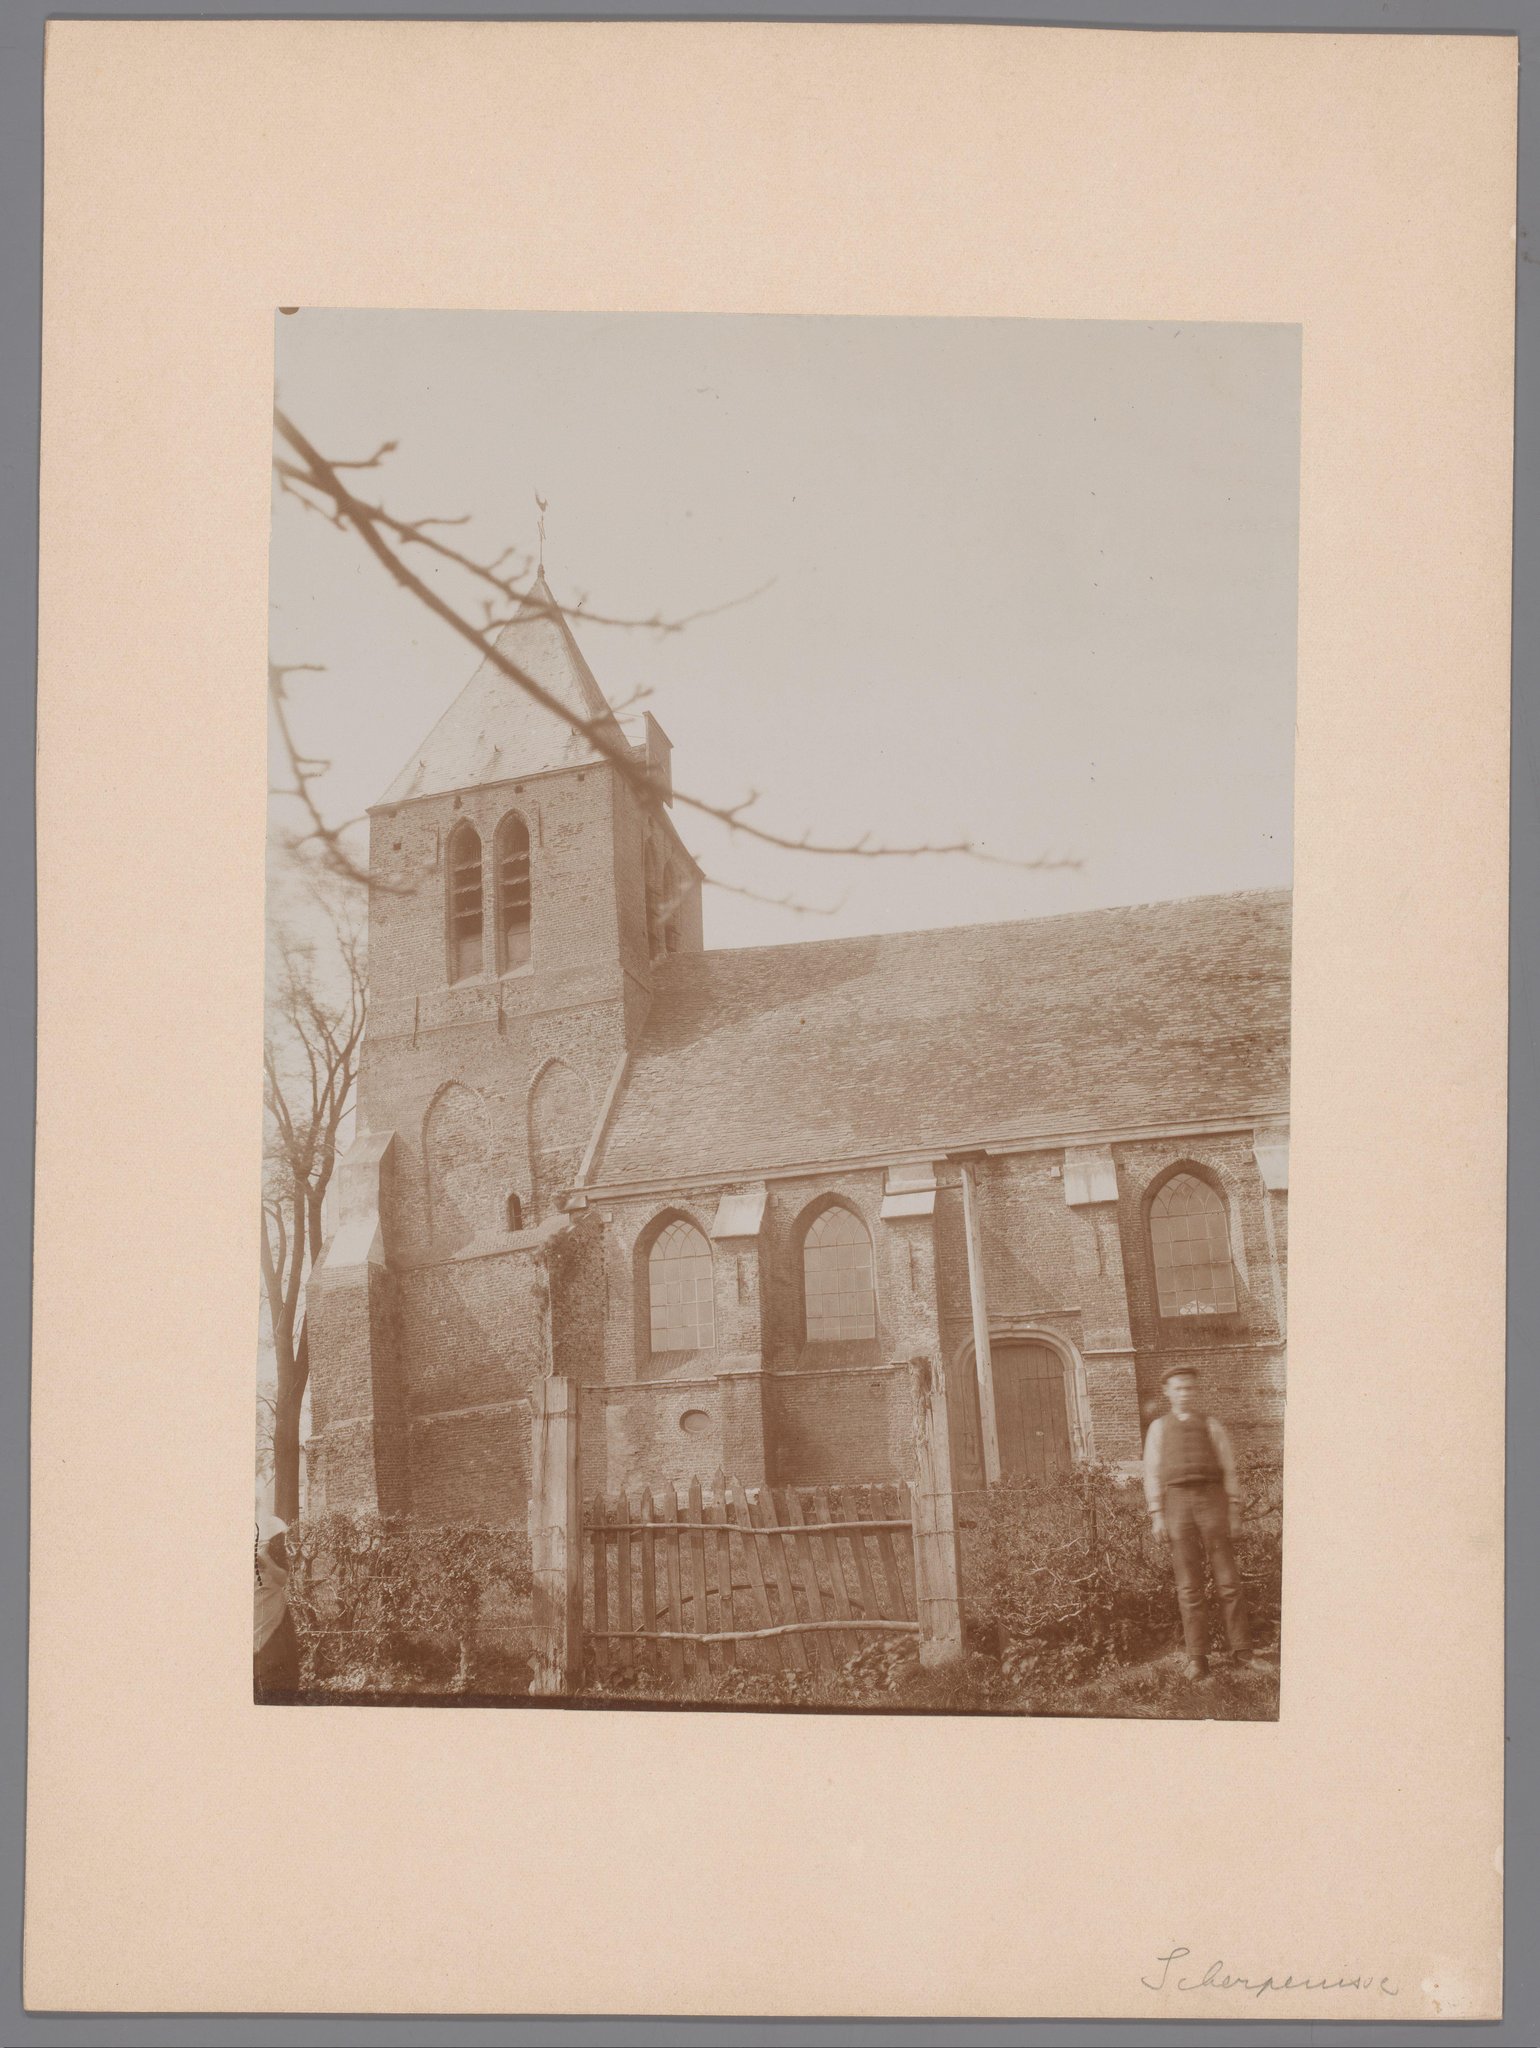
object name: photograph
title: Zuidzijde van het schip van de Hervormde Kerk te Scherpenisse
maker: anoniem (monumentenzorg)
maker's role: fotograaf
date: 1905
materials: cardboard, photographic support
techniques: collodion silver print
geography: scherpenisse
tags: church (exterior)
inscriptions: annotation: ‘Scherpenisse (Z.)/ Zuidzijde van het schip & van den toren/ Mei 1905’, annotation: ‘Scherpenisse’